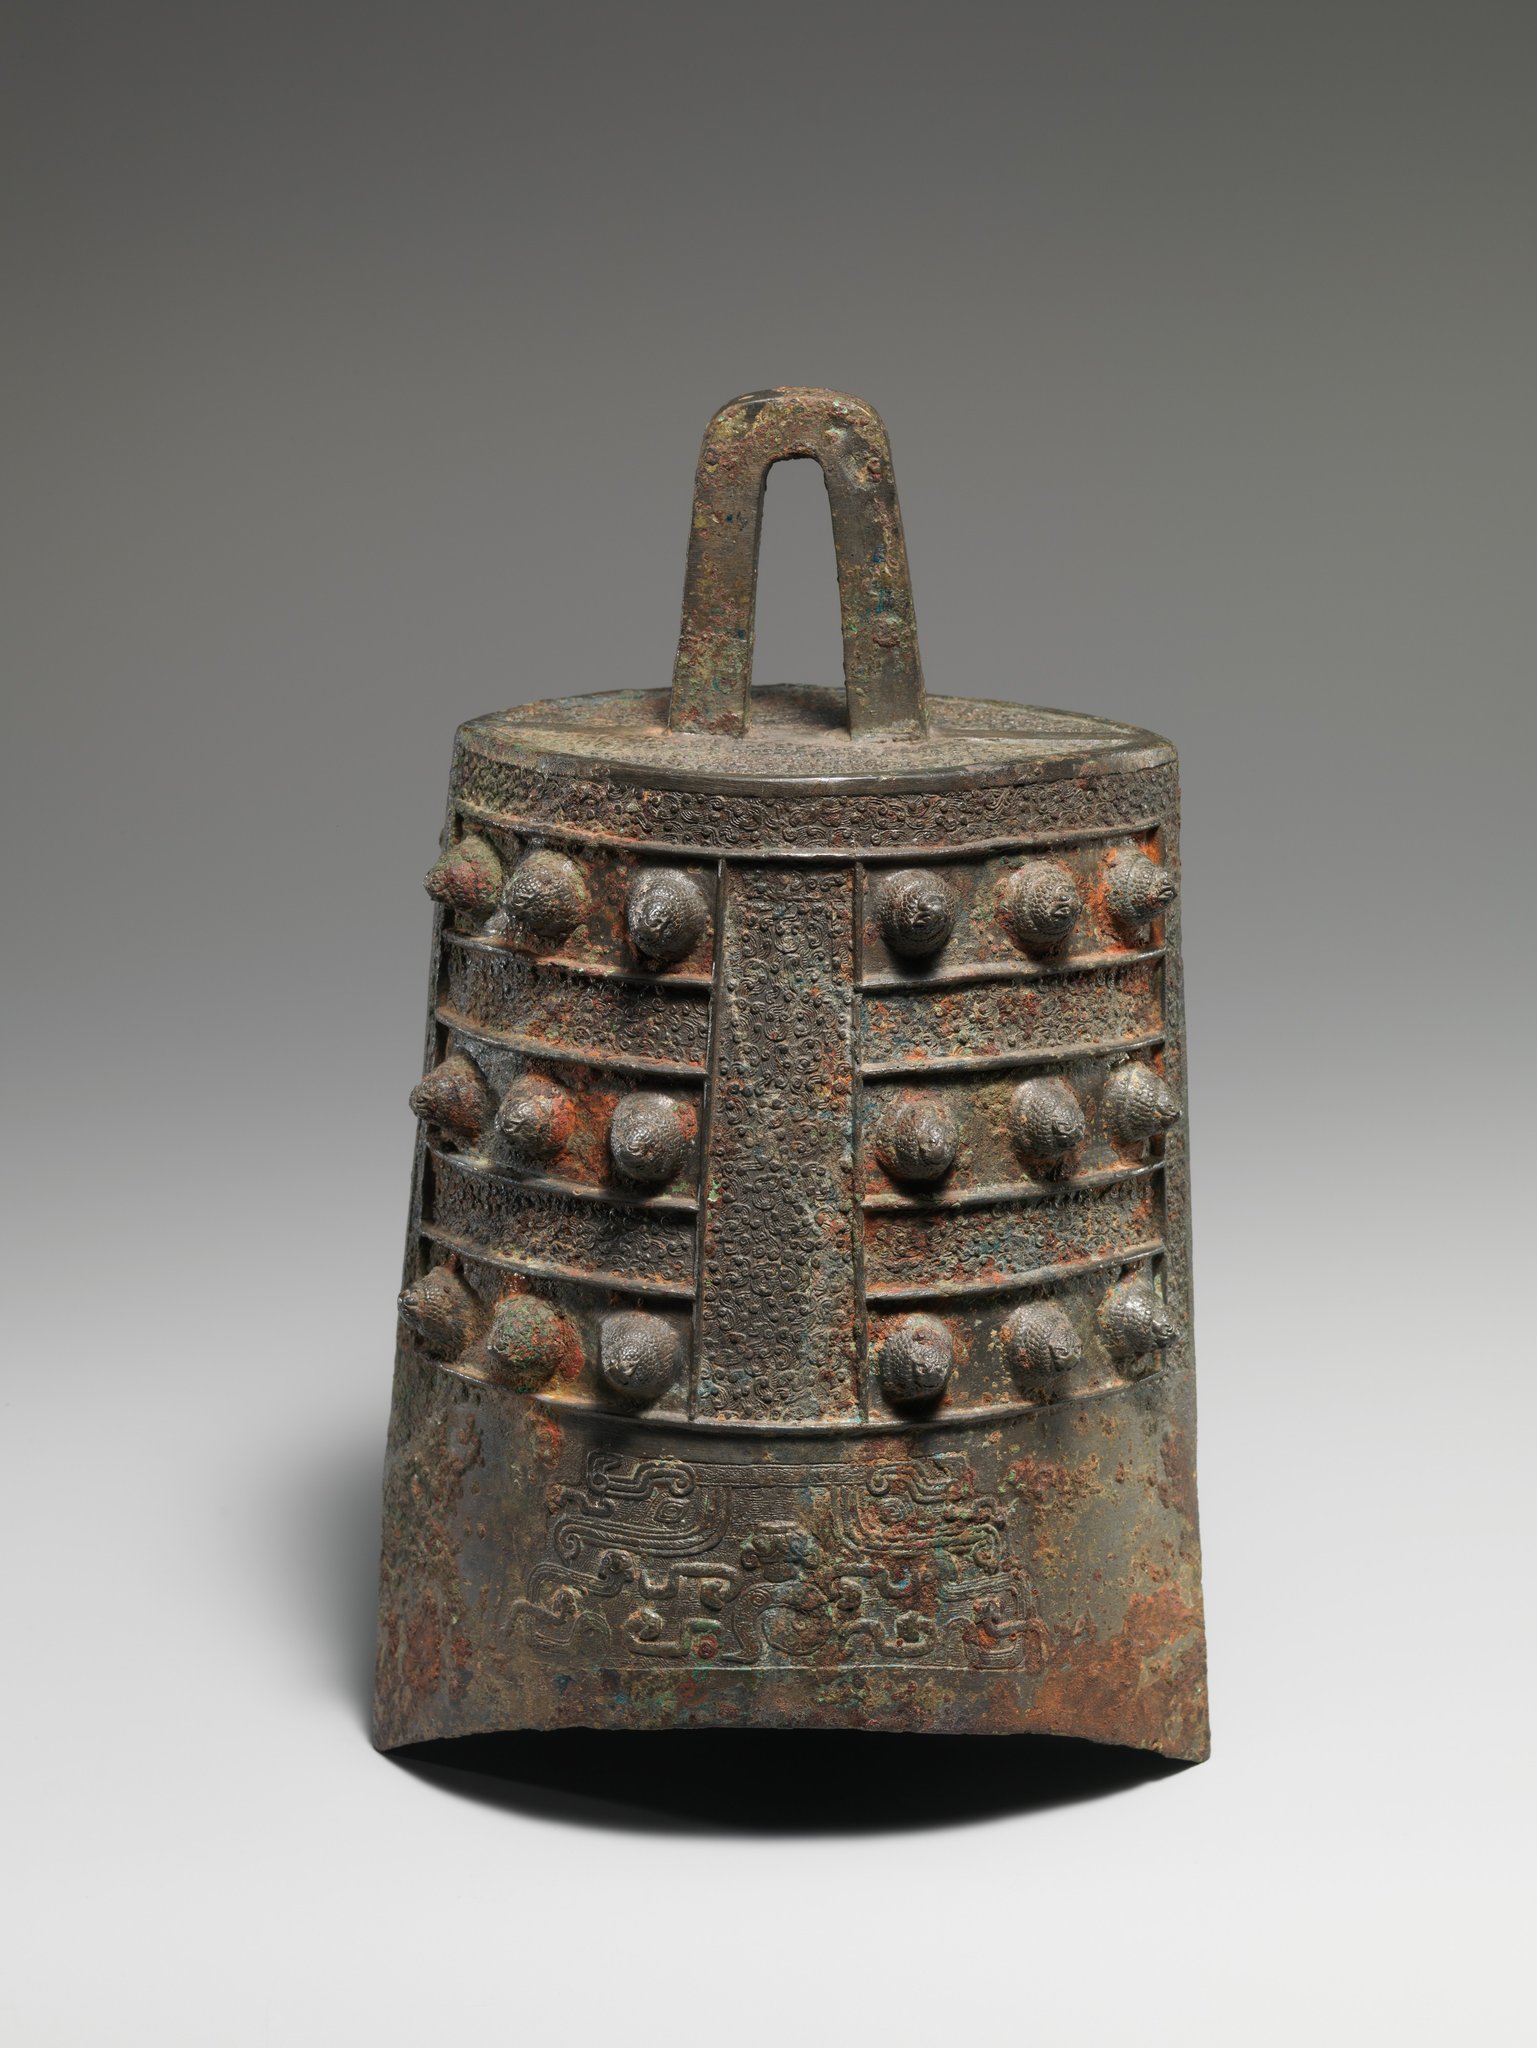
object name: bell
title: Bell (niuzhong)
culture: chinese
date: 500-401 BCE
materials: bronze